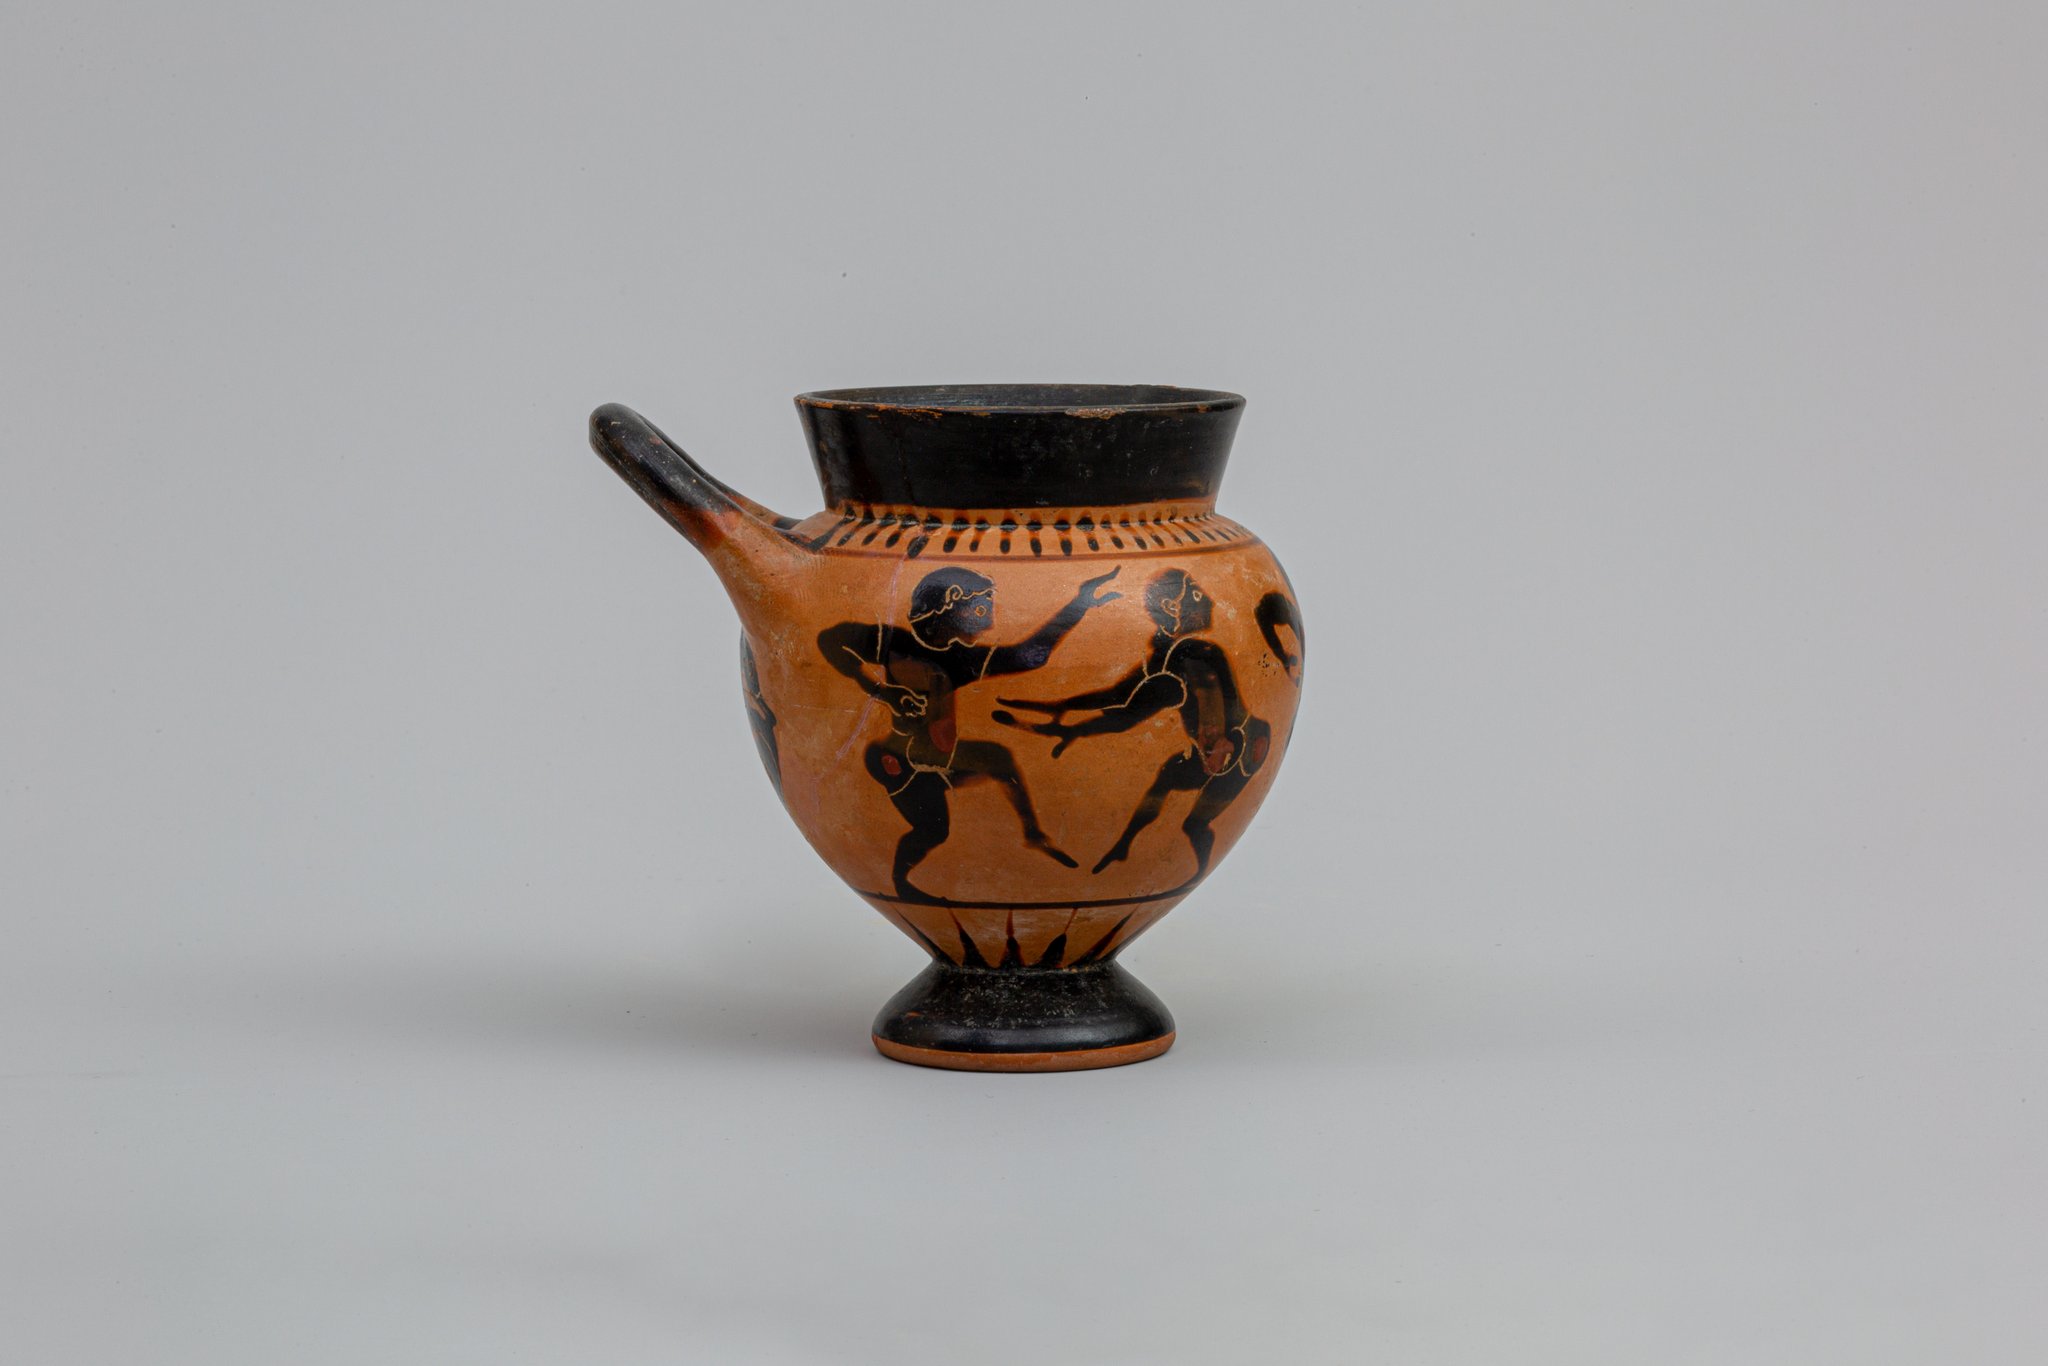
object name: cup, one handled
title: Terracotta one-handled drinking cup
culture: greek, chalcidian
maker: inscription painter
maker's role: artist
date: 550-526 BCE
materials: terracotta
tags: men,dancing